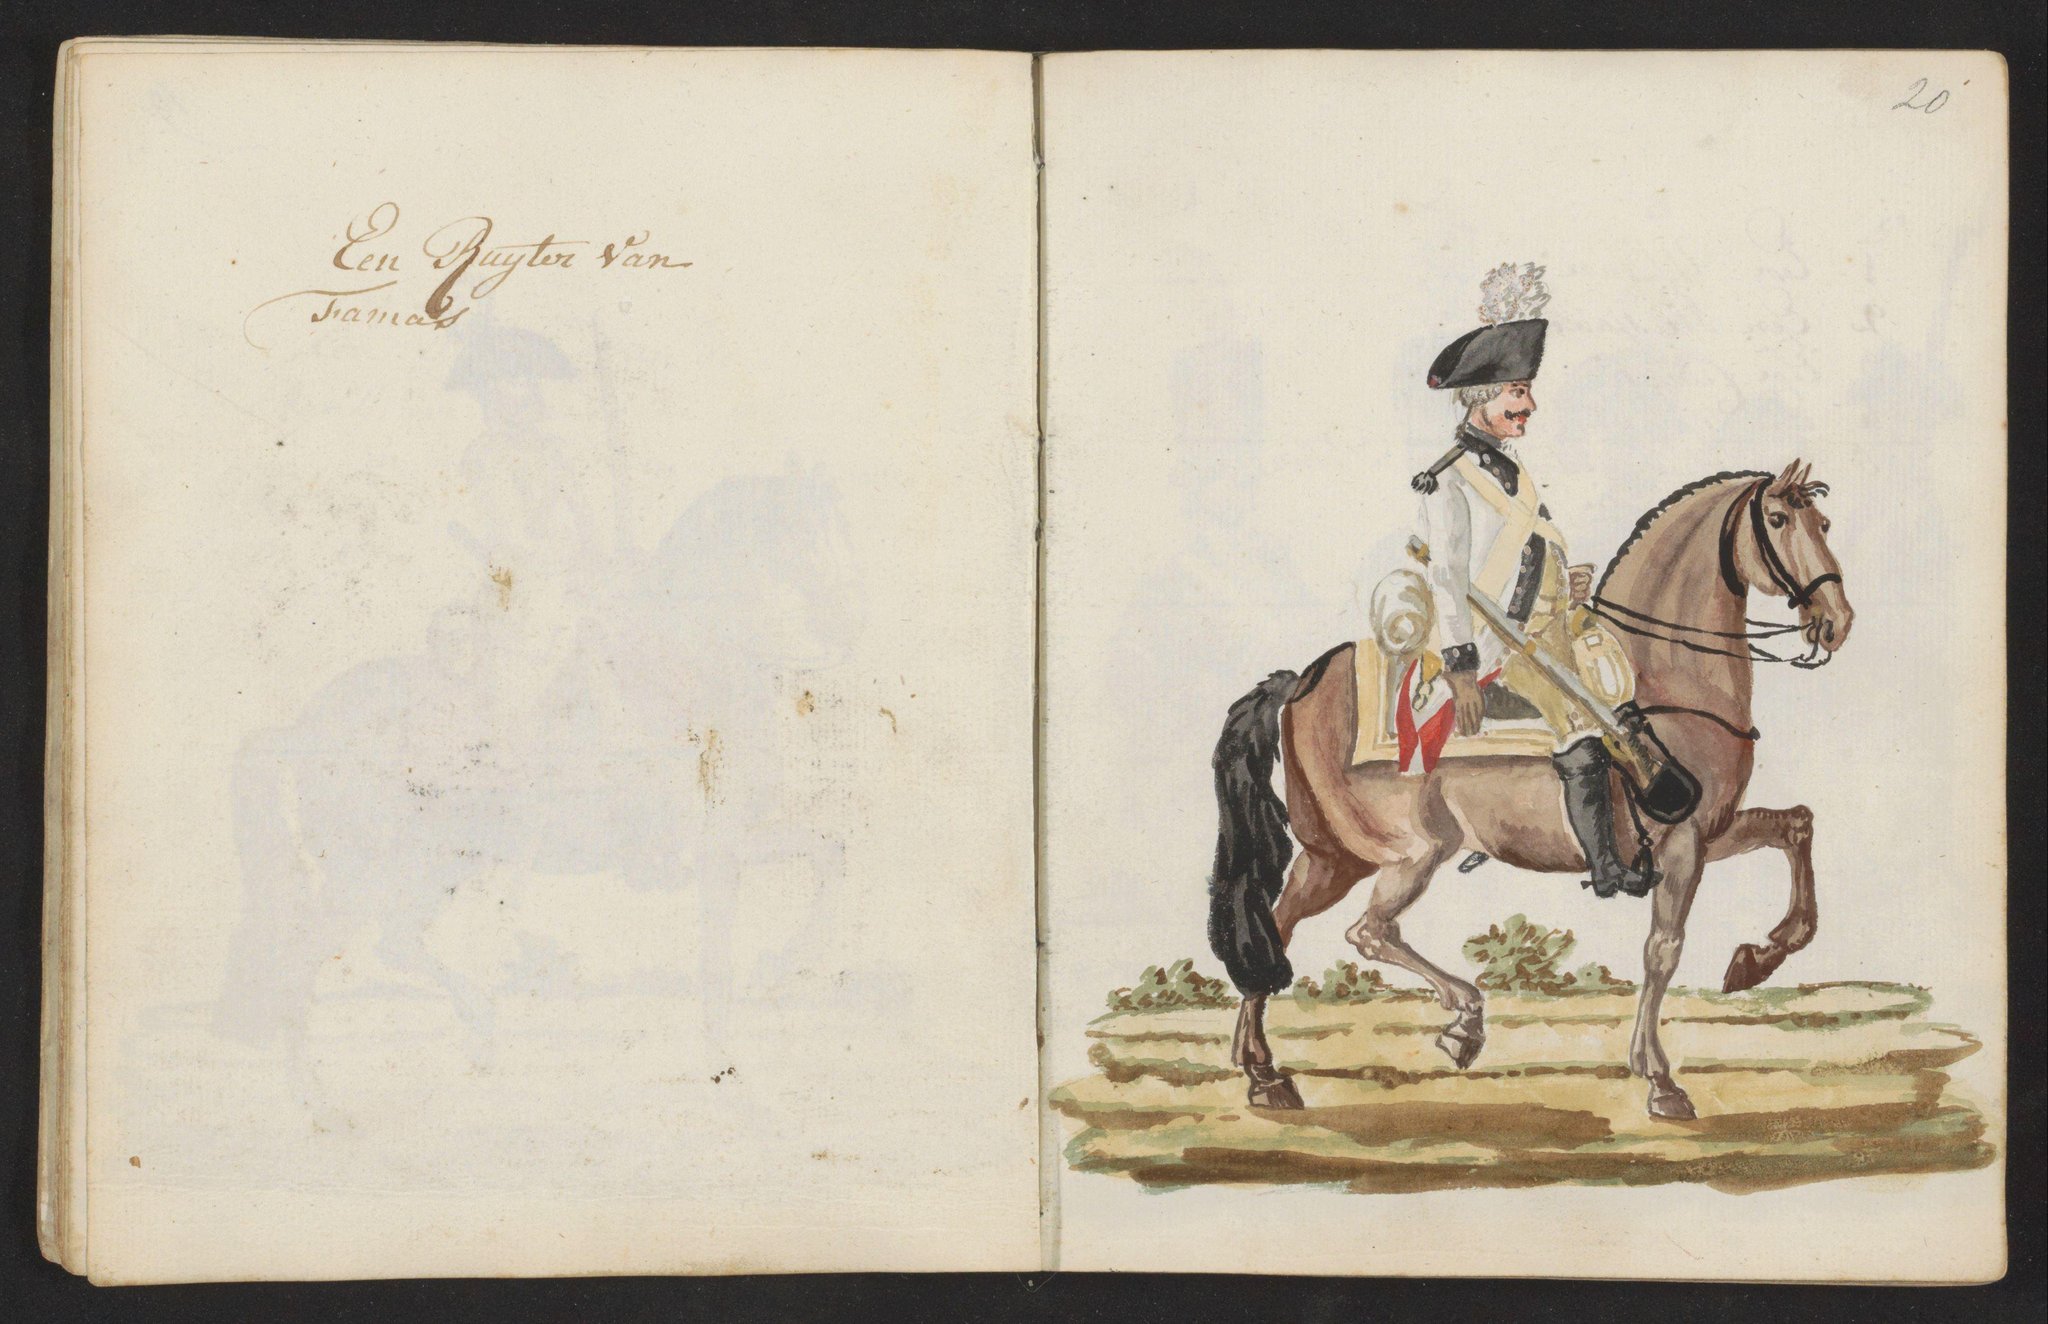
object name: drawing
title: Een Ruyter van Famas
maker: s.g. casten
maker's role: draughtsman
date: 1795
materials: paper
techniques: writing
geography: amsterdam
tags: (military) uniforms (+ land forces), patriots (1780-1795)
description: Het uniform van een ruiter van Famas. Onderdeel van het tweede hoofdstuk over de nieuwe uniformen in de periode 1783-1787. In het schetsboek met gekleurde tekeningen van de uniformen van militairen en leden van de schutterij uit de periode 1770 tot 1795-1796.